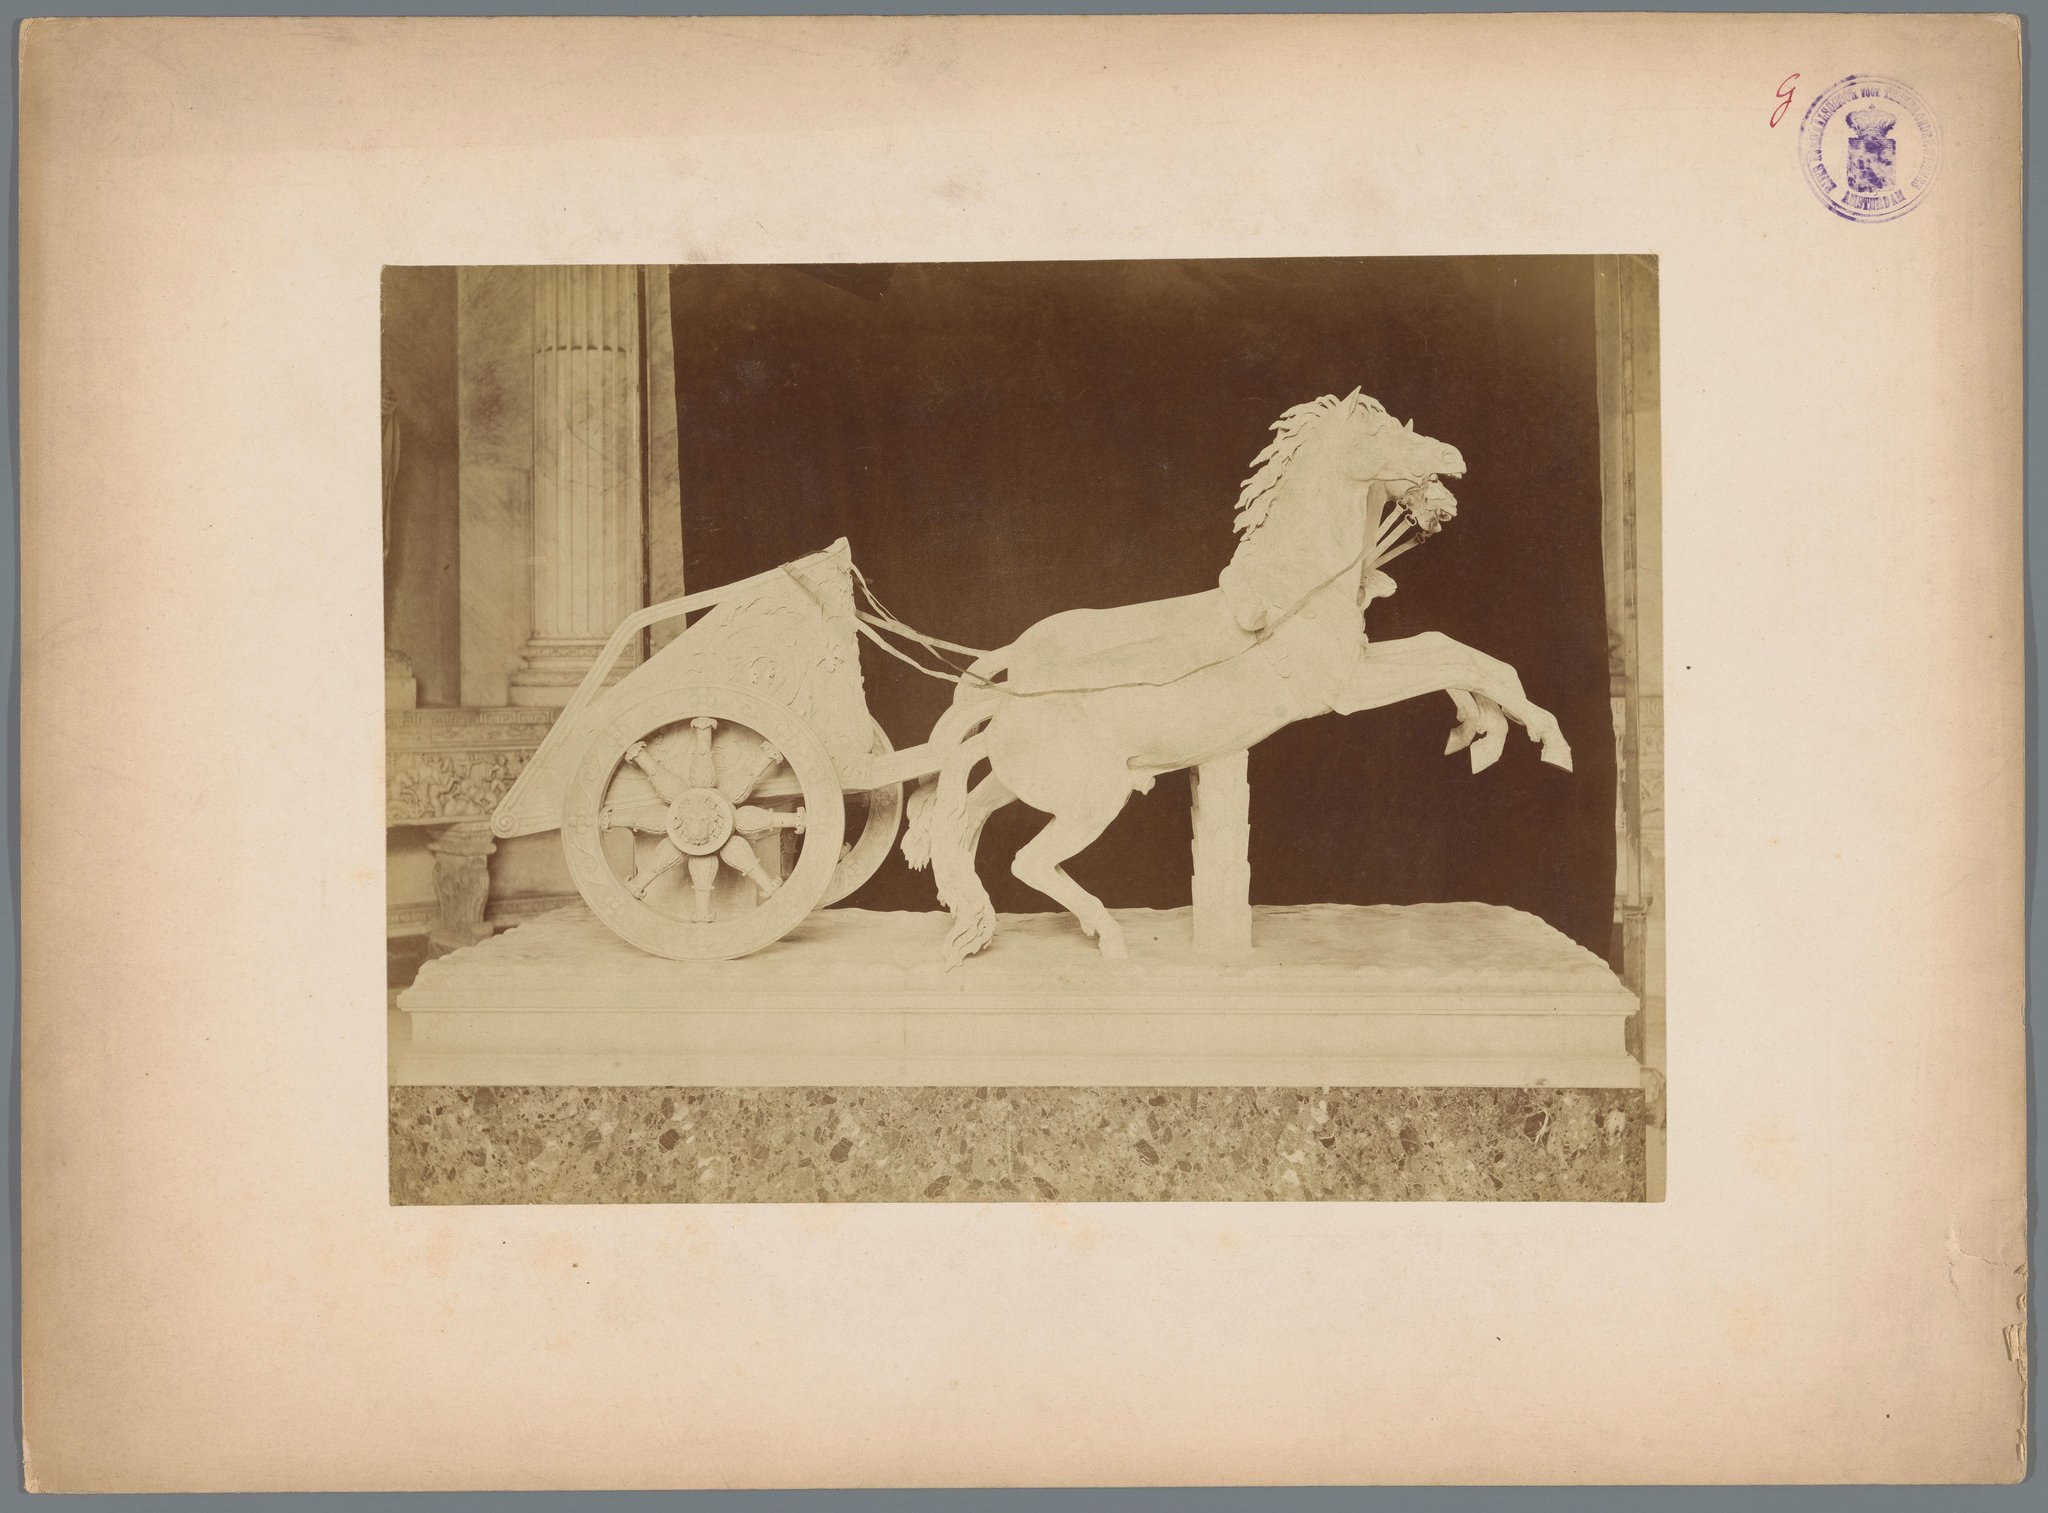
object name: photograph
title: Mogelijk afgietsel van een beeld van twee paarden met een strijdwagen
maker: Anonymous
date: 1850-1900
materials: cardboard, photographic support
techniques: albumen print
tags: chariot, triumphal car, horse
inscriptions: stamp: ‘AT[...]’, collector's mark: ‘Rijks normaalschool voor teekenonderwijzers Amsterdam’, inscription: ‘G’